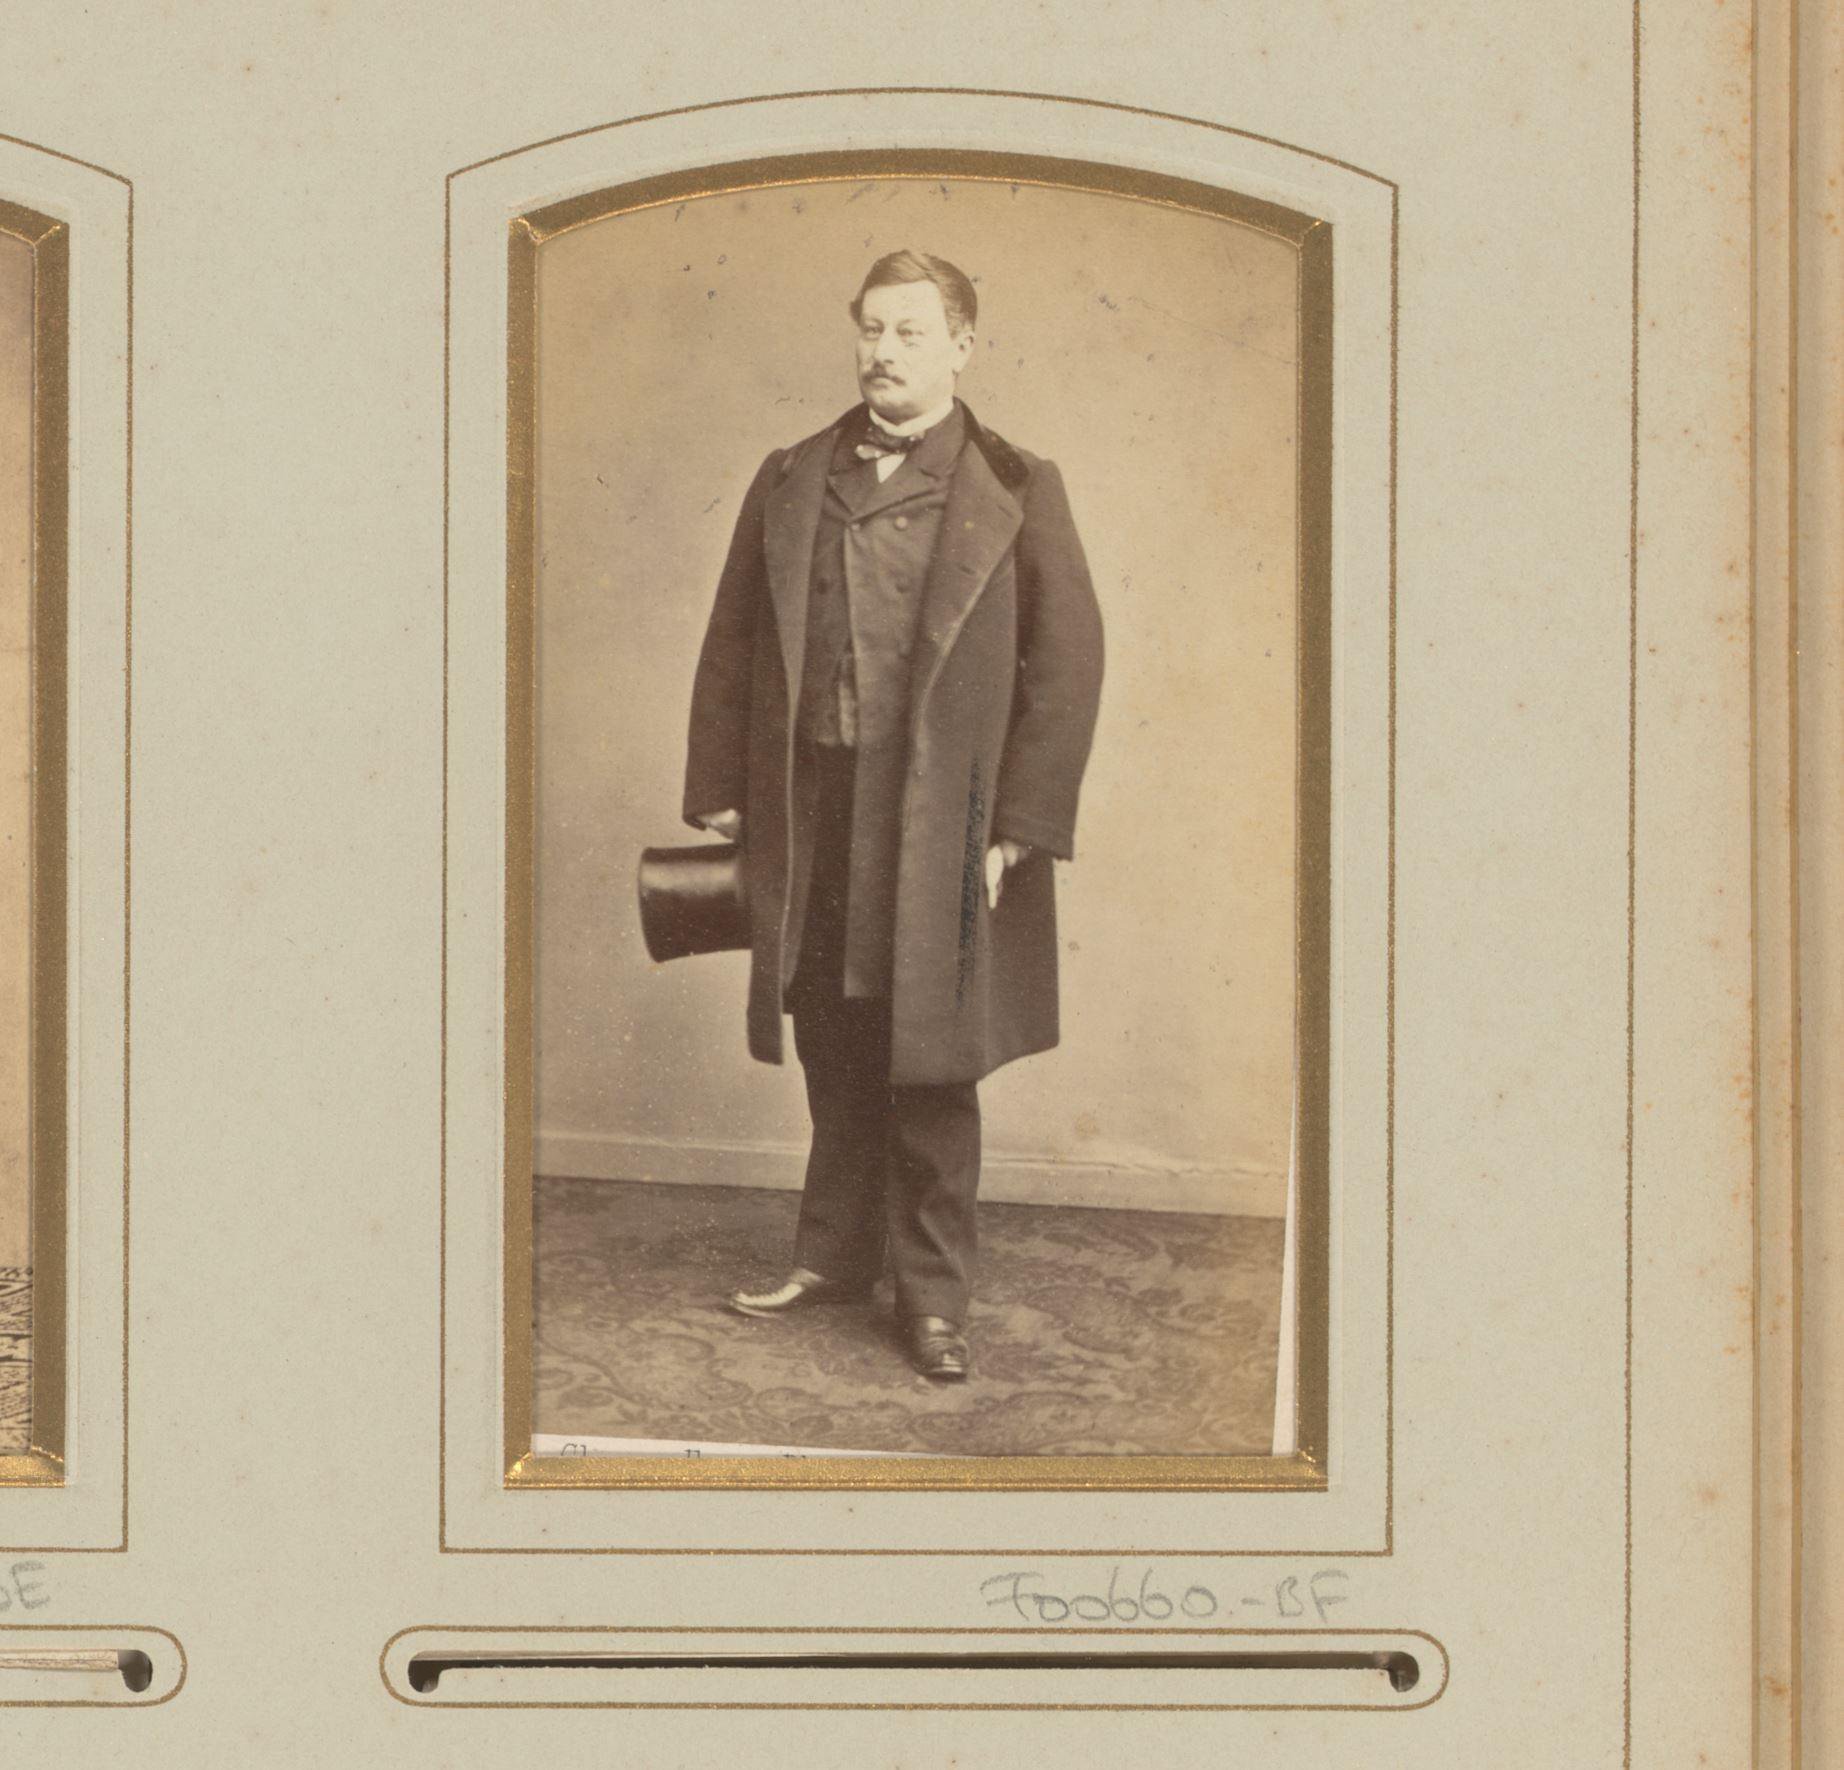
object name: photograph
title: Portret van een staande man met hoed in de hand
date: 1860-1894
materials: cardboard, photographic support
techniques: albumen print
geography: brussels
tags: historical persons, head-gear: top hat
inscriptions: inscription: ‘ATELIER DE PHOTOGRAPHIE./ GHÉMAR FRÈRES./ PHOTOGRAPHES DU ROI,/ 27, rue de l'Ecuyer,/ entrée par la porte cochère,/ BRUXELLES.’